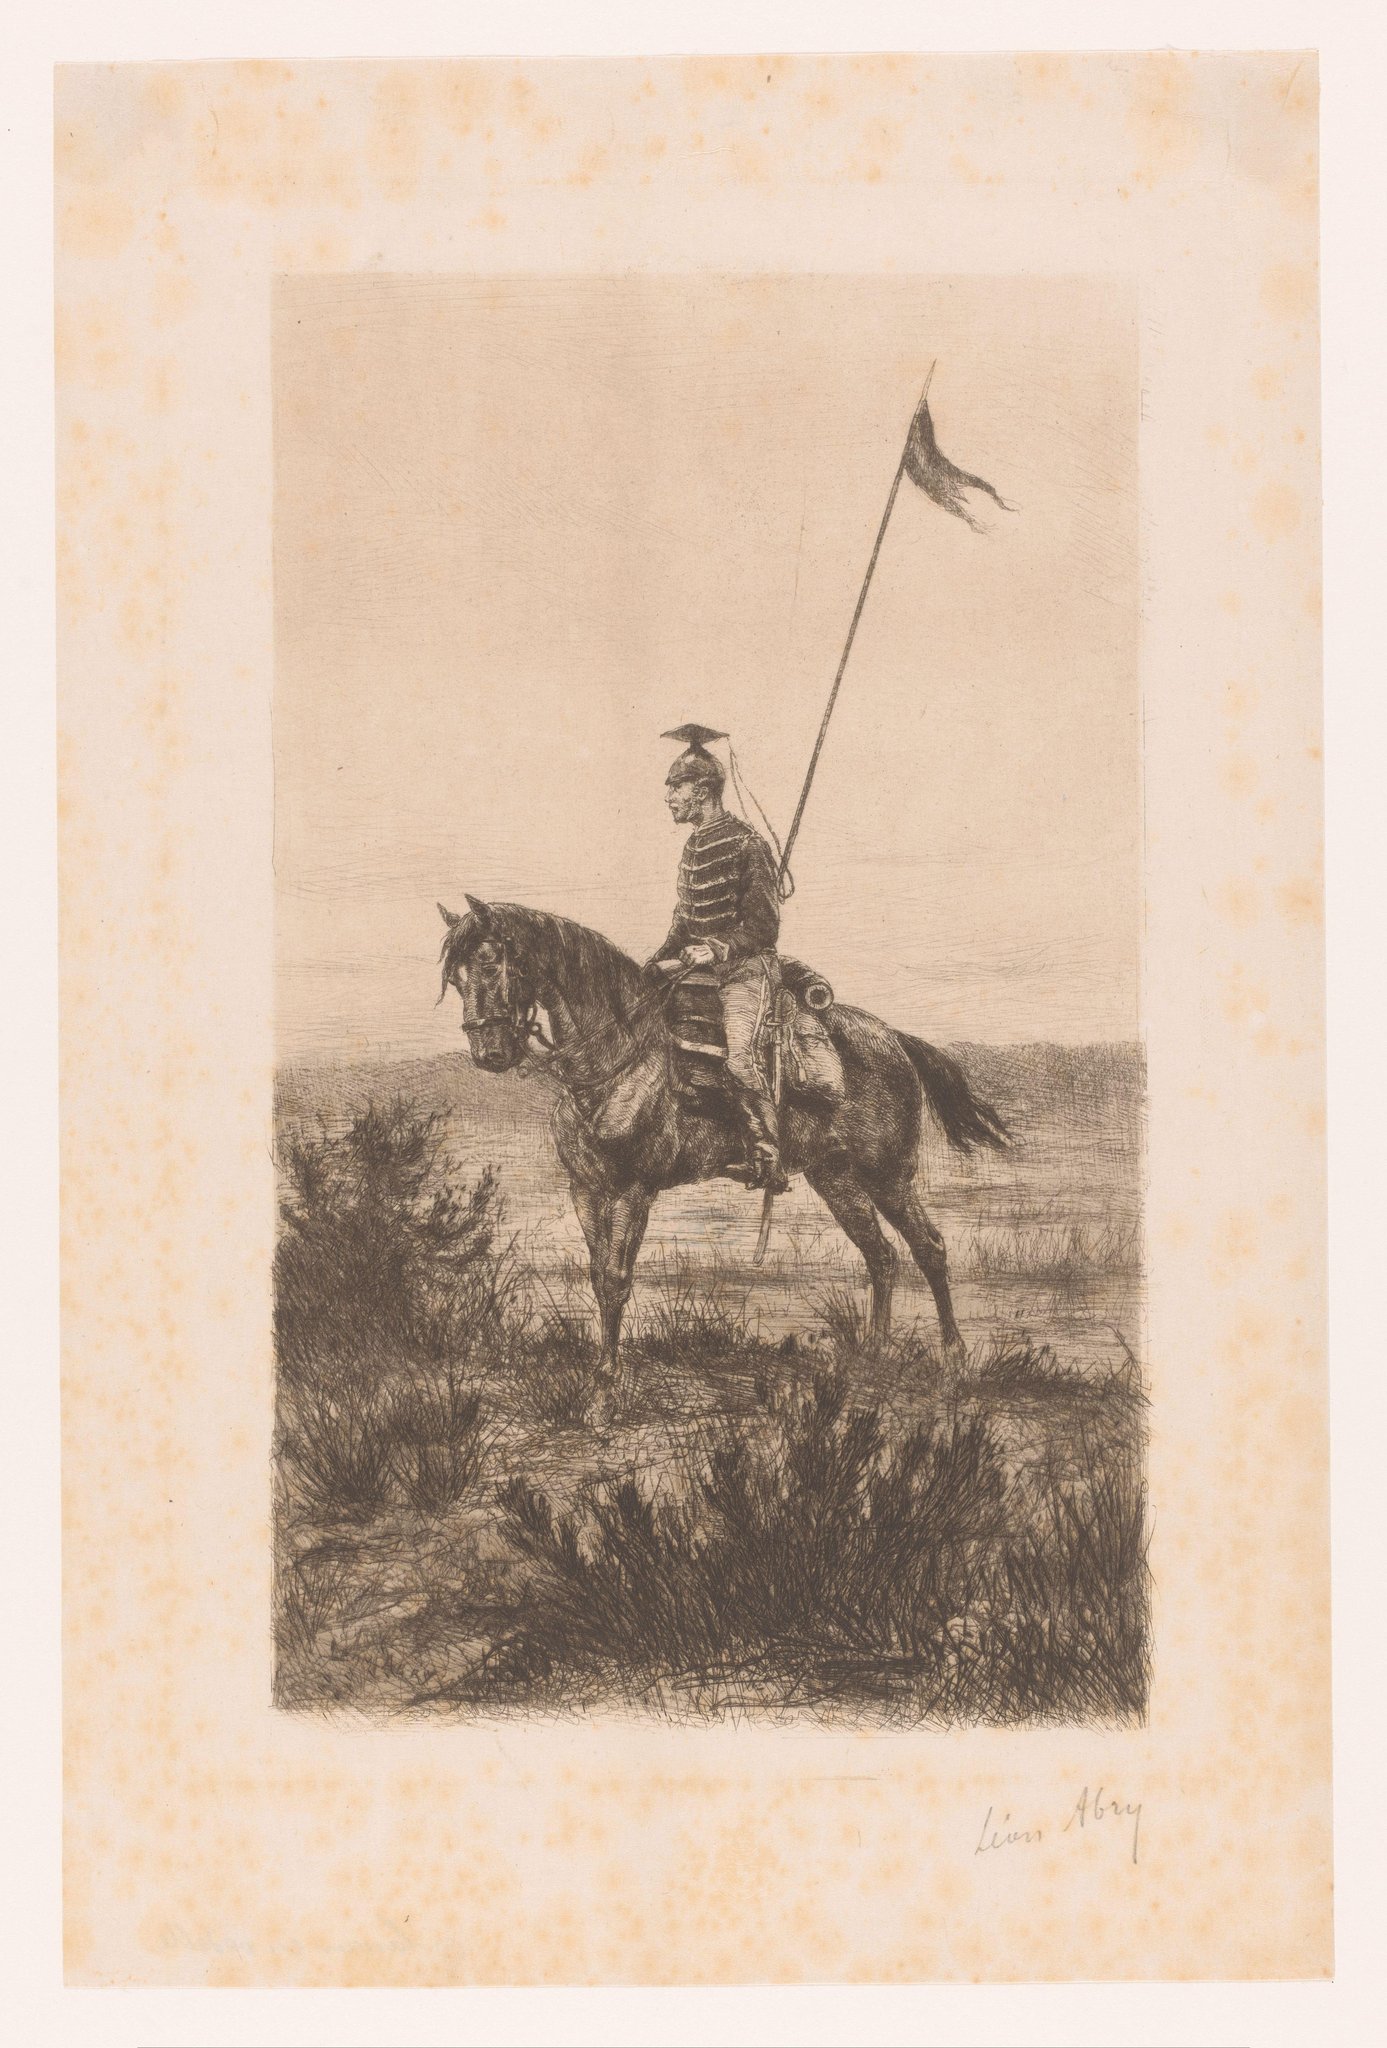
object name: print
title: Lansier te paard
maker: leon eugène auguste abry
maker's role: print maker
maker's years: 1857-1905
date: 1867-1905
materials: paper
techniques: drypoint, etching, intaglio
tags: private soldier (+ cavalry, horsemen), belgium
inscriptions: collector's mark: Lugt 2228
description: Lansier te paard met sabel aan zijn zijde en een wimpel in zijn lans. Op zijn hoofd draagt de cavalerist een chapka.